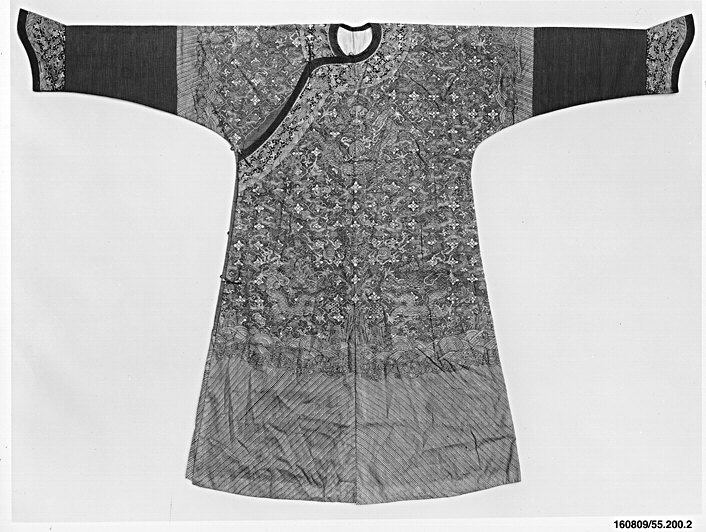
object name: robe, imperial court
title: Imperial Court Robe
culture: chinese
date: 1801-1900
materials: silk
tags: dragons